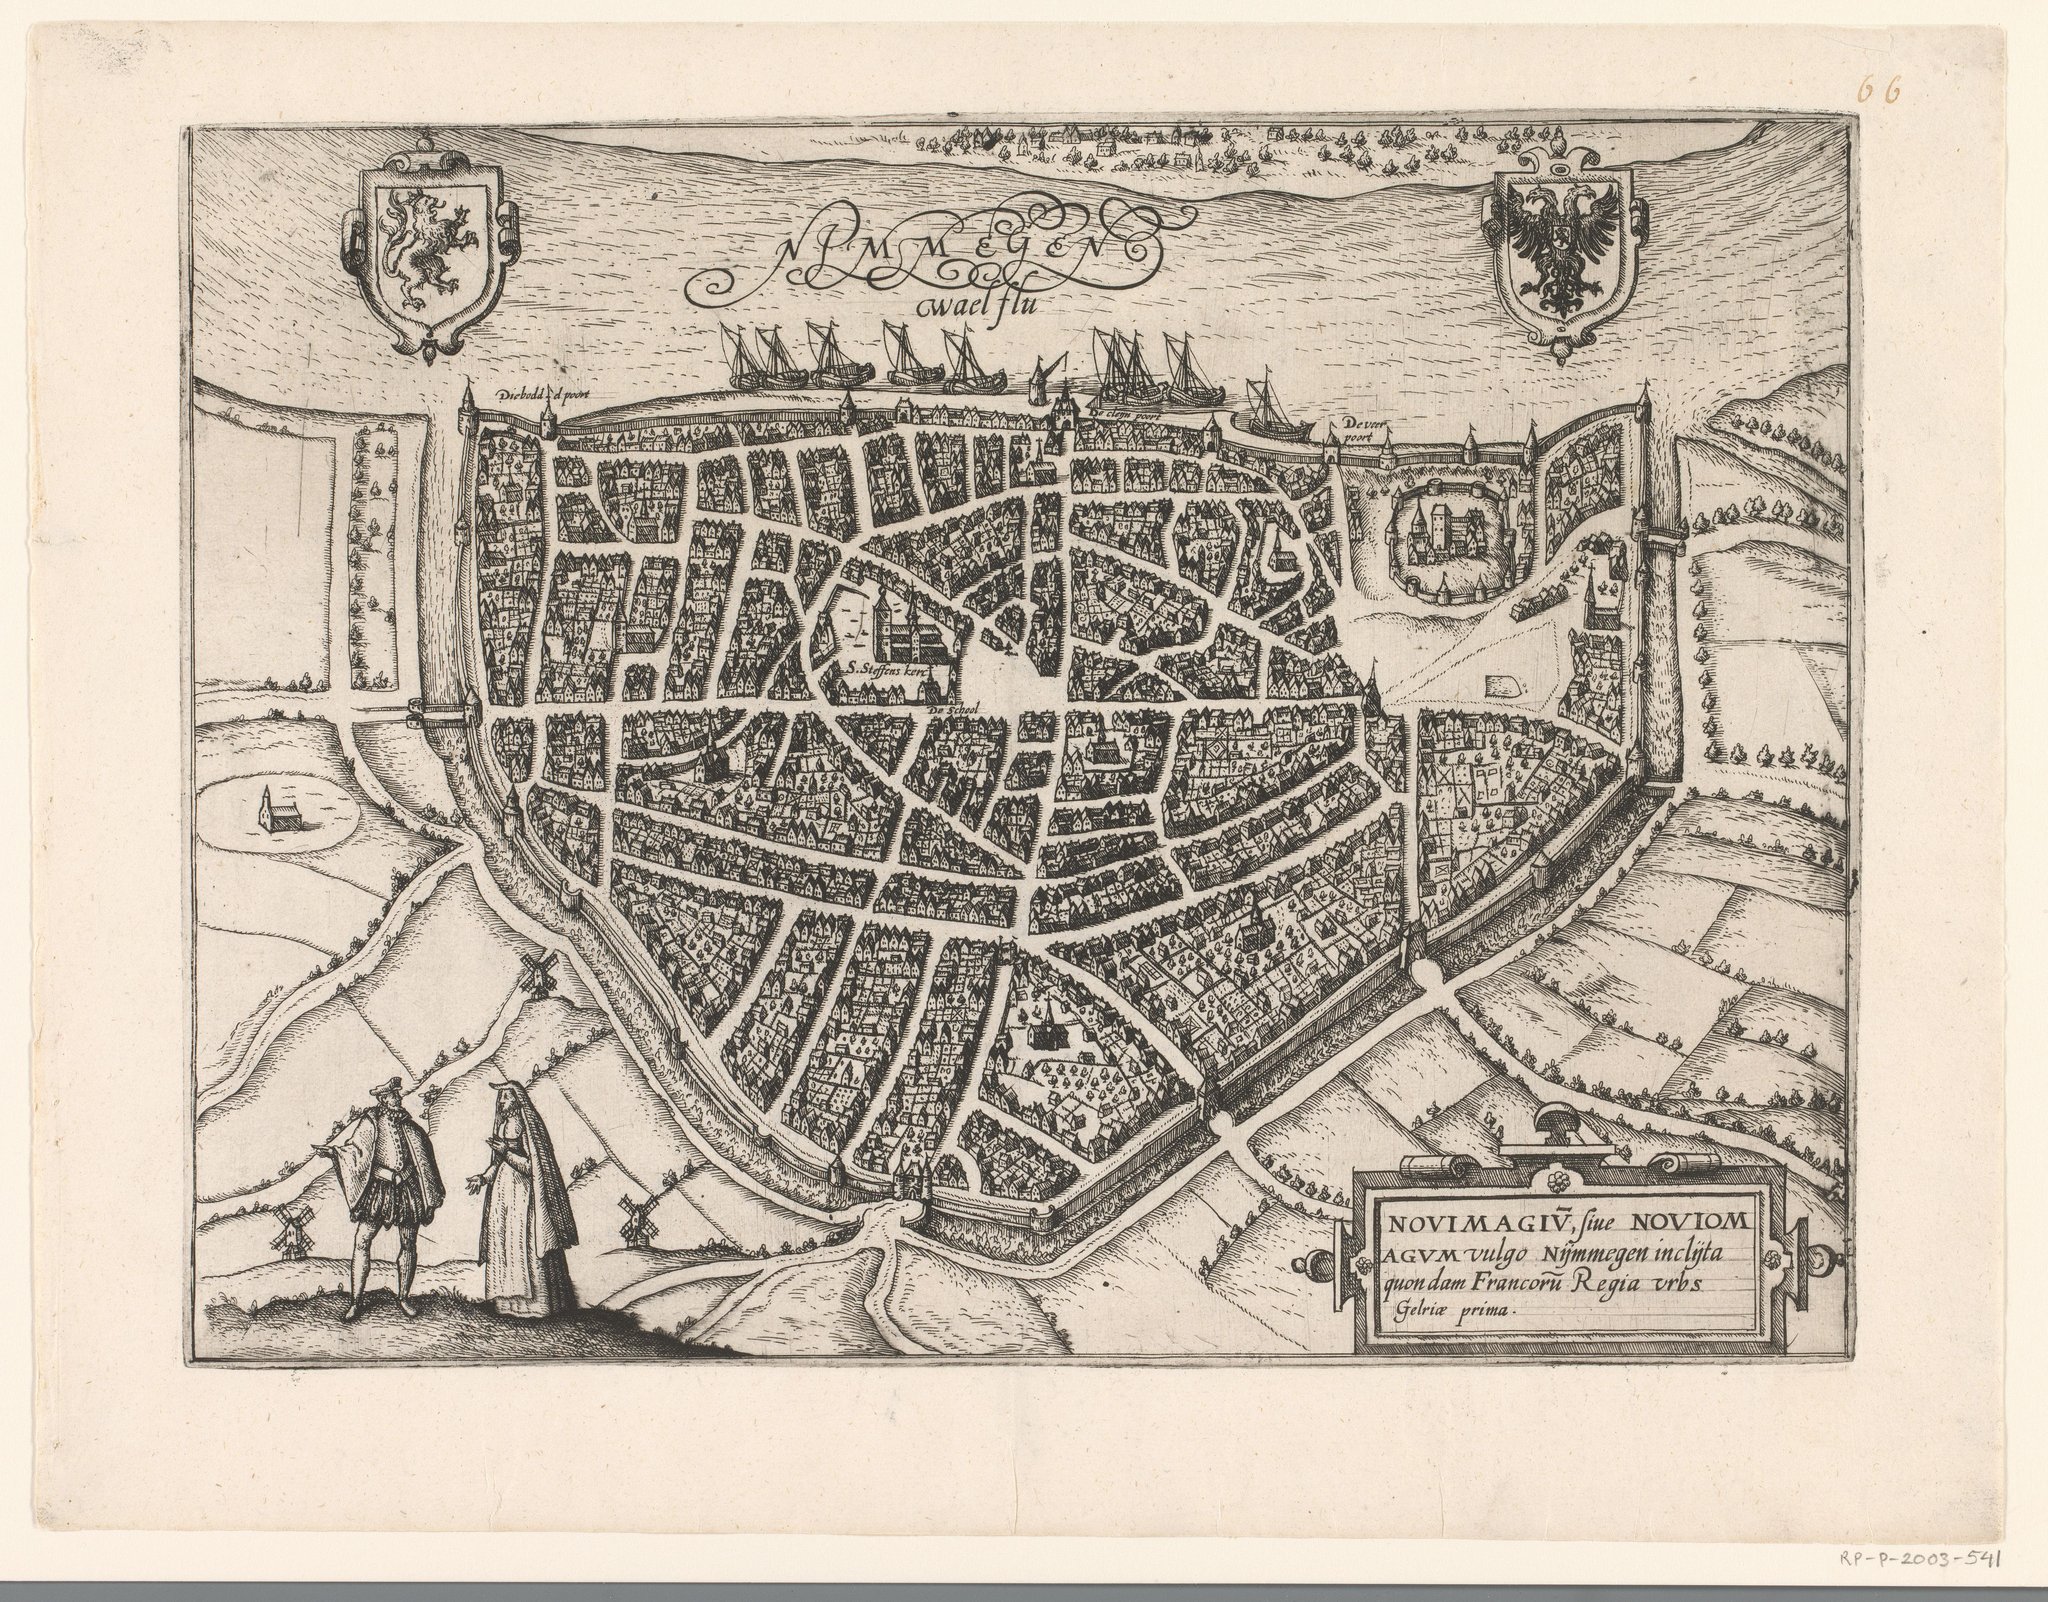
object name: area plan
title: Nimmegen / Novimagiu[m], sive Noviom | agum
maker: Anonymous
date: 1607-1609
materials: paper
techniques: etching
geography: northern netherlands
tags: maps of cities, nijmegen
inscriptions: number: ‘66’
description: Plattegrond van de stad Nijmegen. Midden boven de titel, links het wapen van het hertogdom Gelre, rechts het stadswapen. Rechtsonder een cartouche met de Latijnse titel. Linksonder een man en een vrouw. Onderdeel van de verzameling kaarten genomen uit een latere editie van: Descrittione di tutti i Paesi Bassi van Lodovico Guicciardini.